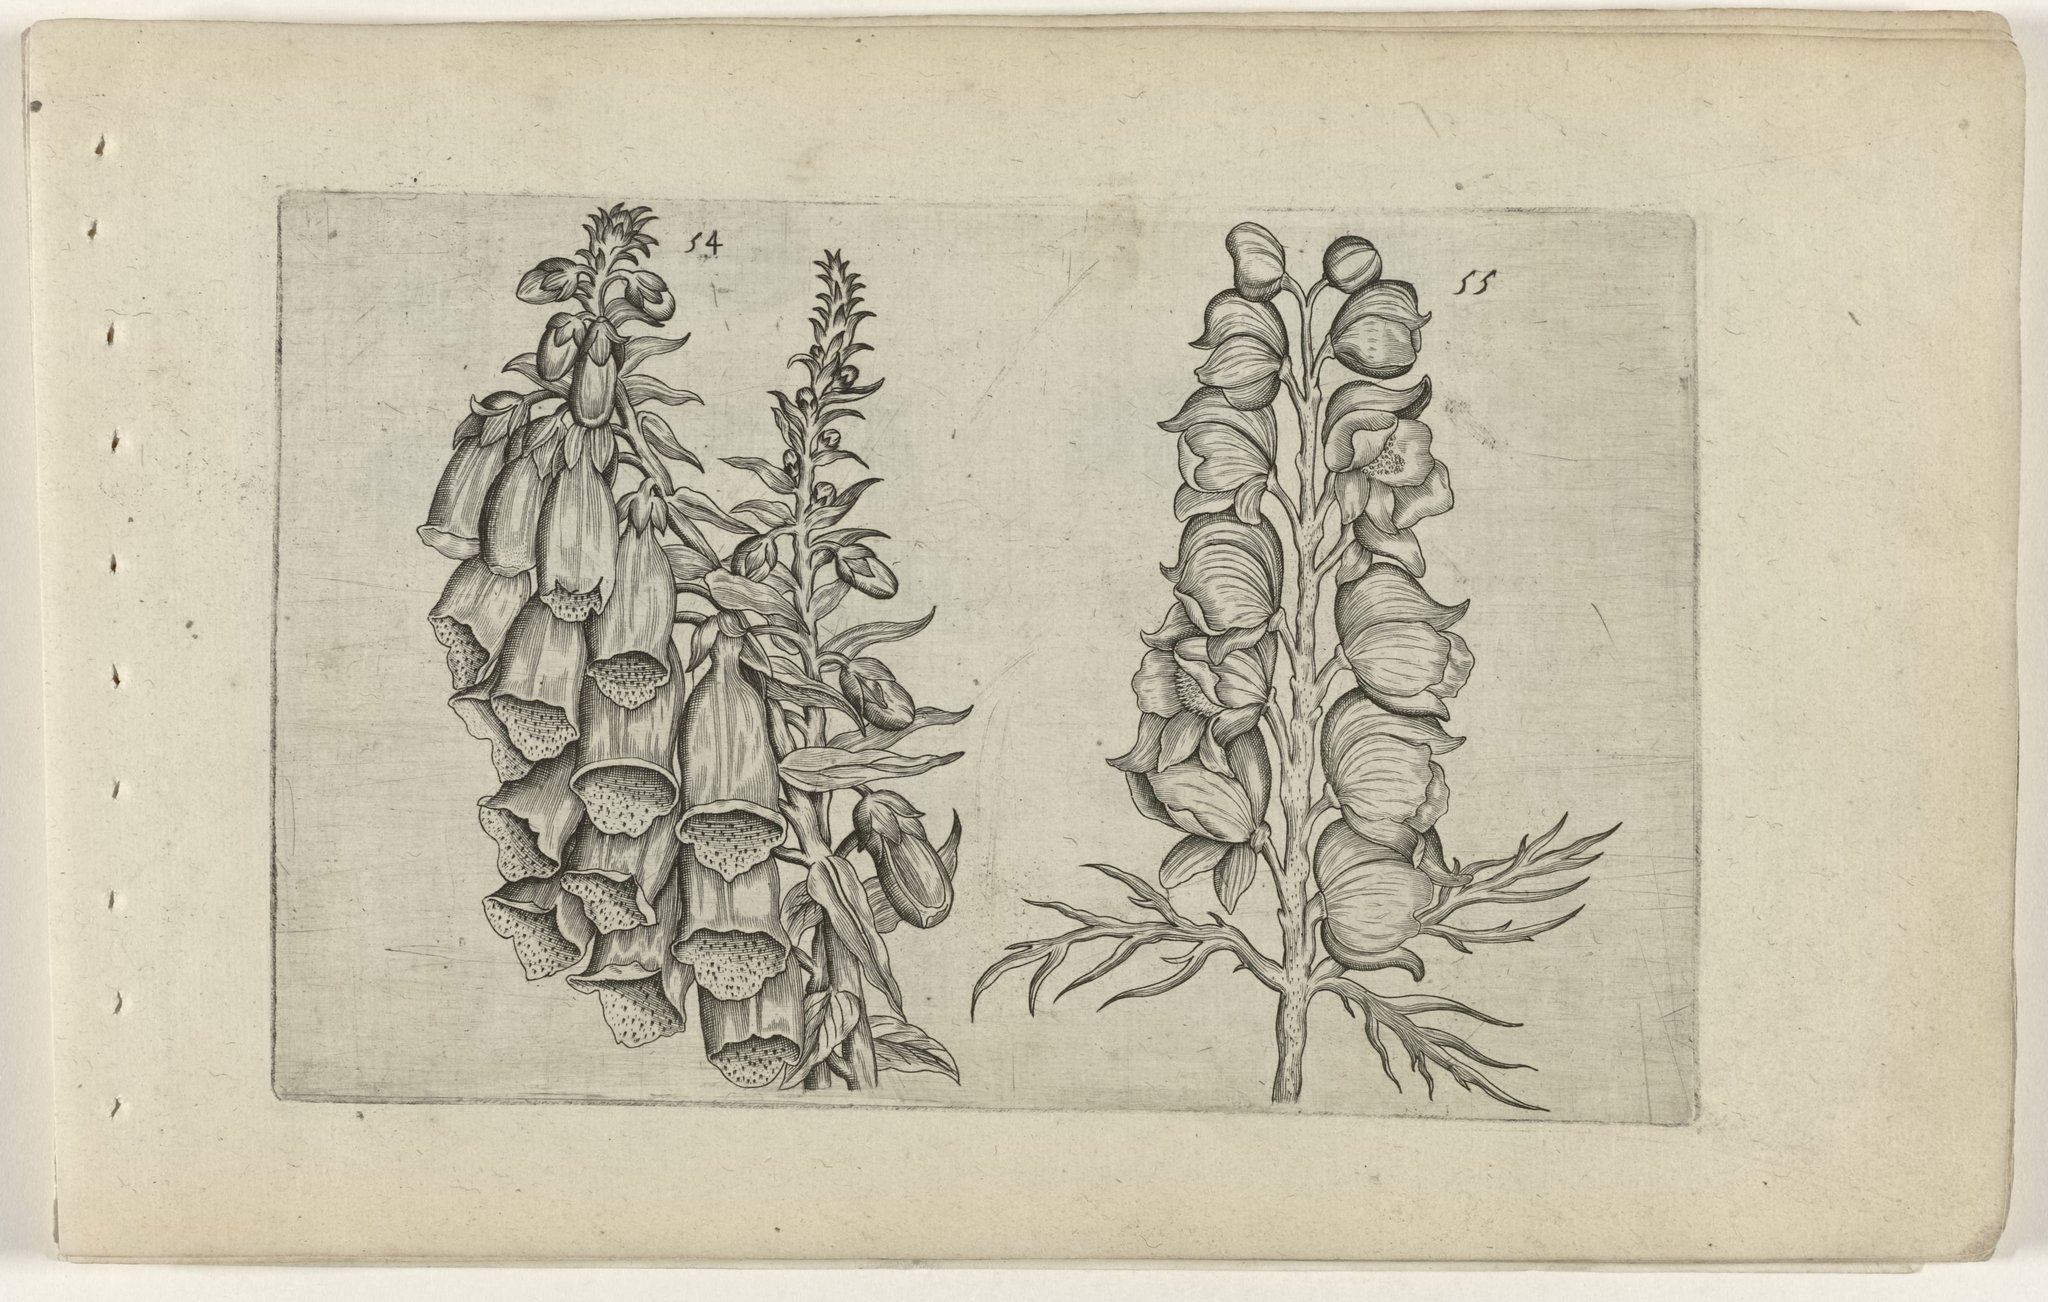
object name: print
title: Vingerhoedskruid en blauwe monnikskap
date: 1600-1604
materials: paper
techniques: engraving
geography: cologne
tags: flowers: monkshood, flowers: foxglove, botany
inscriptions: collector's mark: Lugt 2228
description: De prenten RP-P-2012-24-1 t/m 61 waren oorspronkelijk als serie samengebonden. De naaigaten op de bladen zijn nog zichtbaar. Het betreft de reeks getiteld: Cognoscite lilia, bestaande uit een titelprent en 60 gravures met 119 genummerde weergaven van planten, bloemen en vruchten, versierd met rinceaux en kleine voorstellingen van dieren. Het gaat om proefdrukken van deze reeks gravures, voor de opschriften en, deels, voor de nummering. Op enkele prenten zijn de nummers met de hand aangebracht. Op de titelprent ontbreekt nog het adres van Crispijn de Passe en Hans Woutneel. De titel is hoogstwaarschijnlijk gegraveerd door Matthias Quad. Deze werkte voor De Passe in Keulen tot 1604. De reeks moet in dit jaar of daarvoor tot stand zijn gebracht. In ieder geval voor 1608, aangezien de uitgever Hans Woutneel in of voor dat jaar overleed. In ieder geval voor 1608, aangezien de uitgever Hans Woutneel in of voor dat jaar overleed. De gravures worden door Ilja Veldman en Anthony Griffiths beschouwd als eigenhandig werk van Crispijn de Passe I. Een van de prenten uit de reeks ontbreekt (nr 21-22) en is vervangen door een ingekleurde afdruk uit een latere uitgave (RP-P-2012-24-61), die onder de titel Altera Pars is opgenomen in de Hortus Floridus, uitgegeven door Crispijn de Passe I en die verder bestaat uit platen van Crispijn de Passe II. De prenten afkomstig uit deze uitgave zijn op de verso voorzien van tekst in boekdruk. De vervangende prent maakte geen deel uit van de gebonden serie aangezien dit blad als enige geen naaigaten heeft. Een deel van de planten, bloemen en vruchten in de Cognoscite lilia gaat terug of is gebaseerd op een reeks aquarellen van Jacques LeMoyne uit circa 1580 en uit 1585, nu in het Victoria and Albert Museum en de British Museum (zie P. Hulton, Jacques LeMoyne, Londen 1977, dl 1, p. 156-162 en p. 165-173).